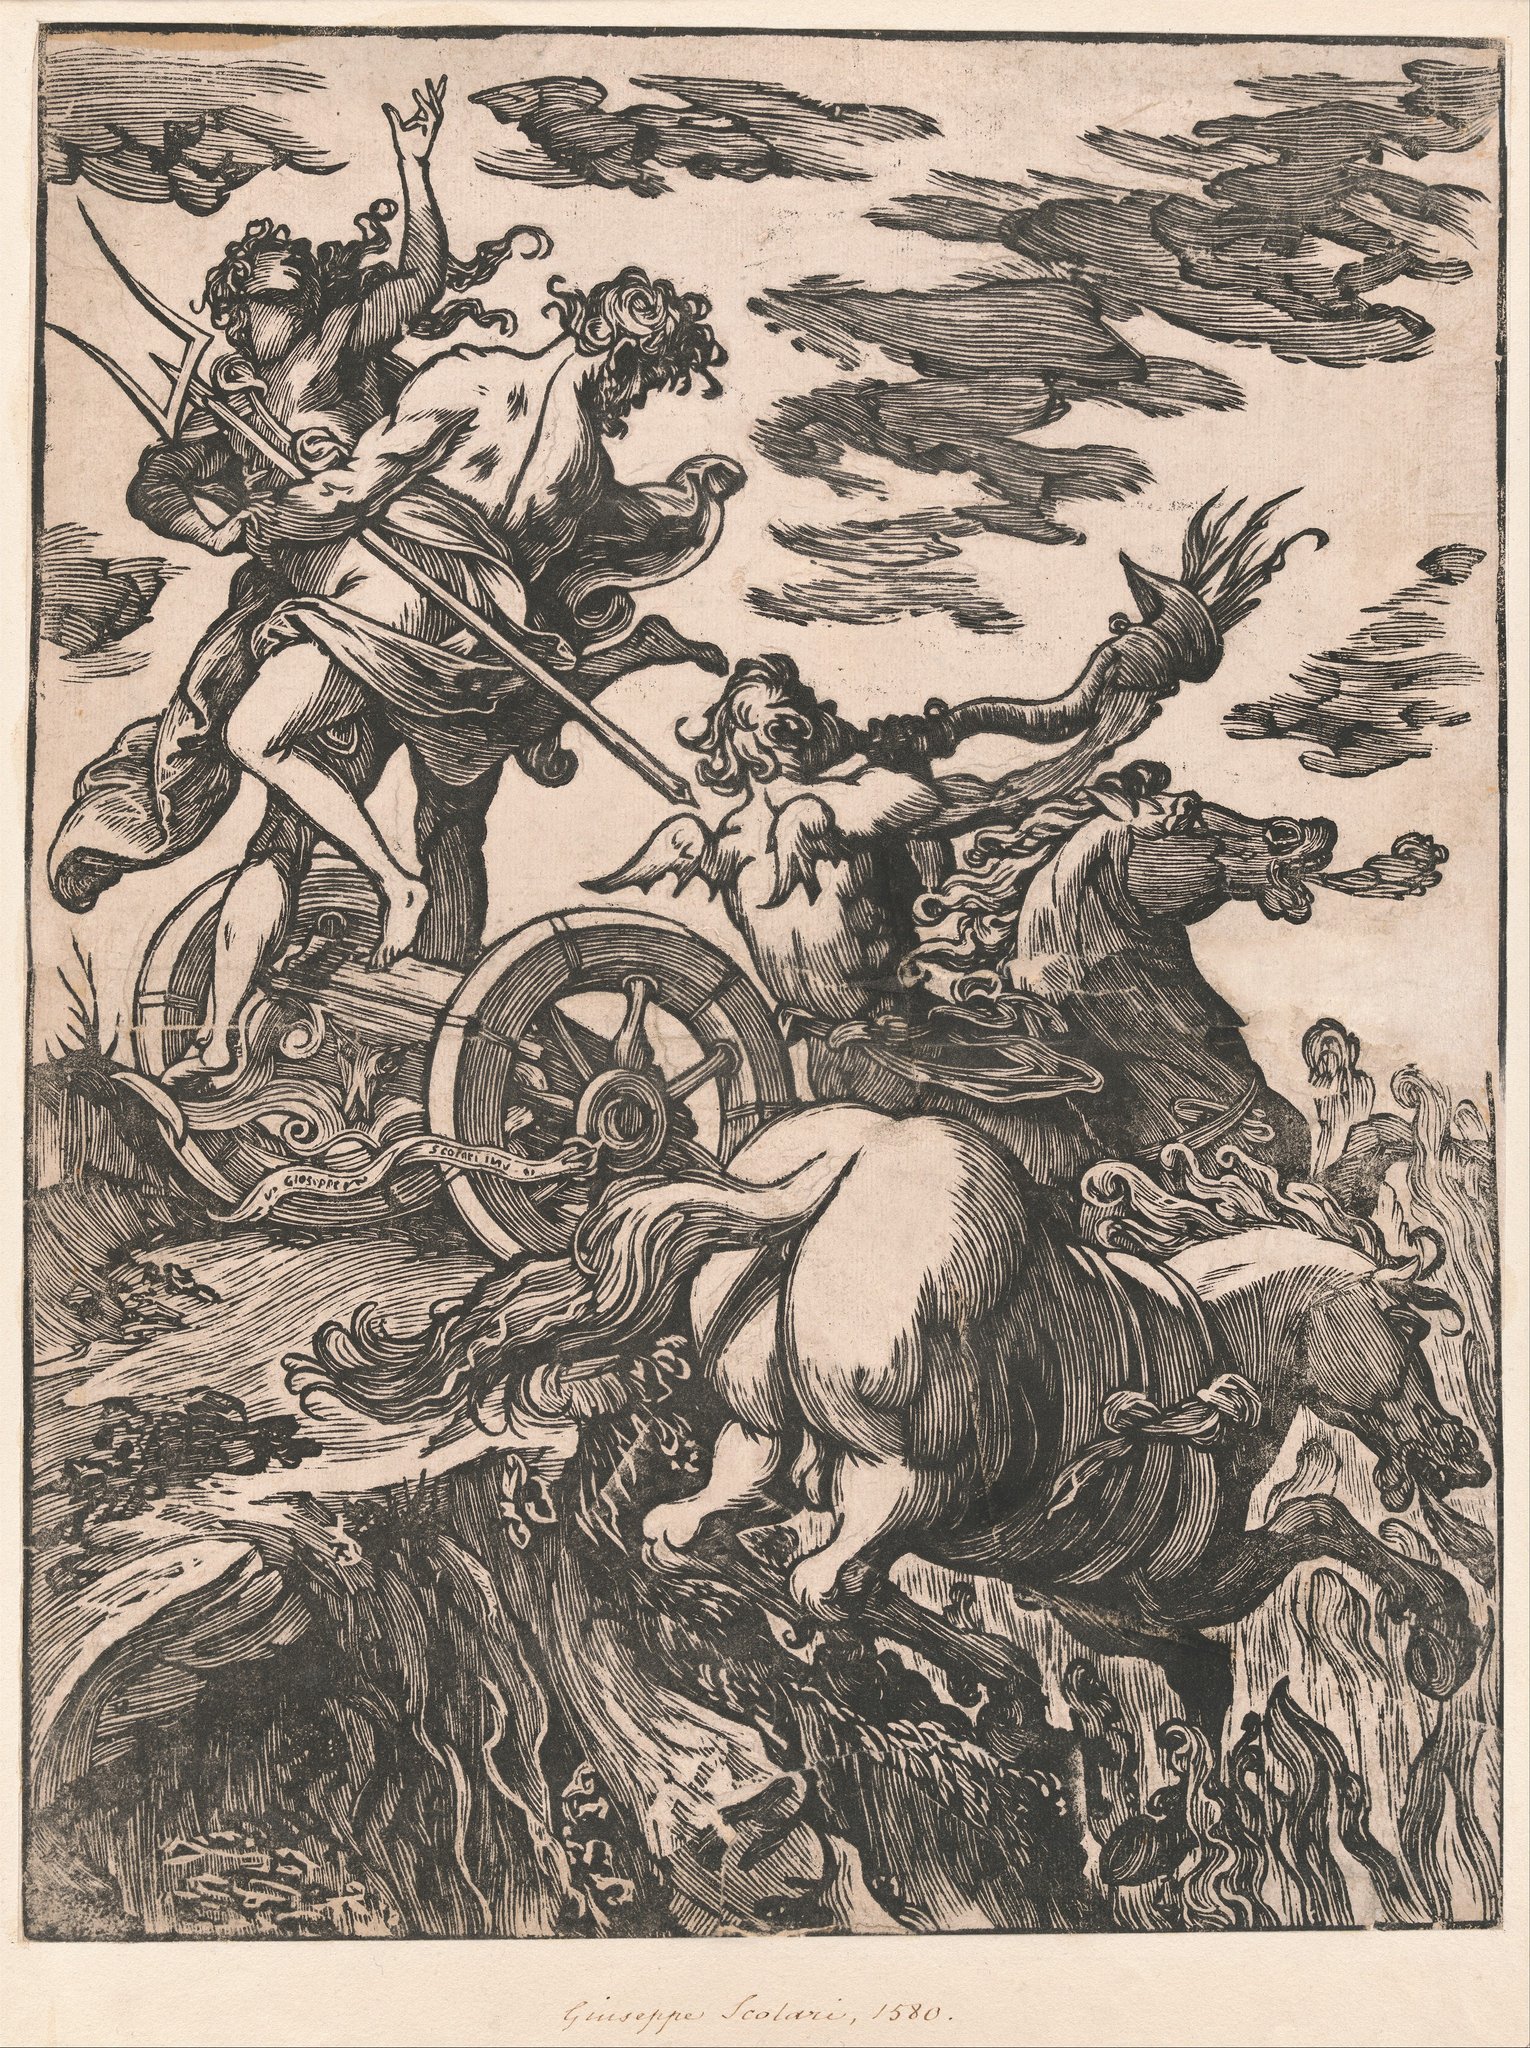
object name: print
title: Rape of Persephone with Pluto on horseback at right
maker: giuseppe scolari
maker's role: artist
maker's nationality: italian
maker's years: 1562-1607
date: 1590-1607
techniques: woodcut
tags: men,women,horses,chariots,persephone,pluto